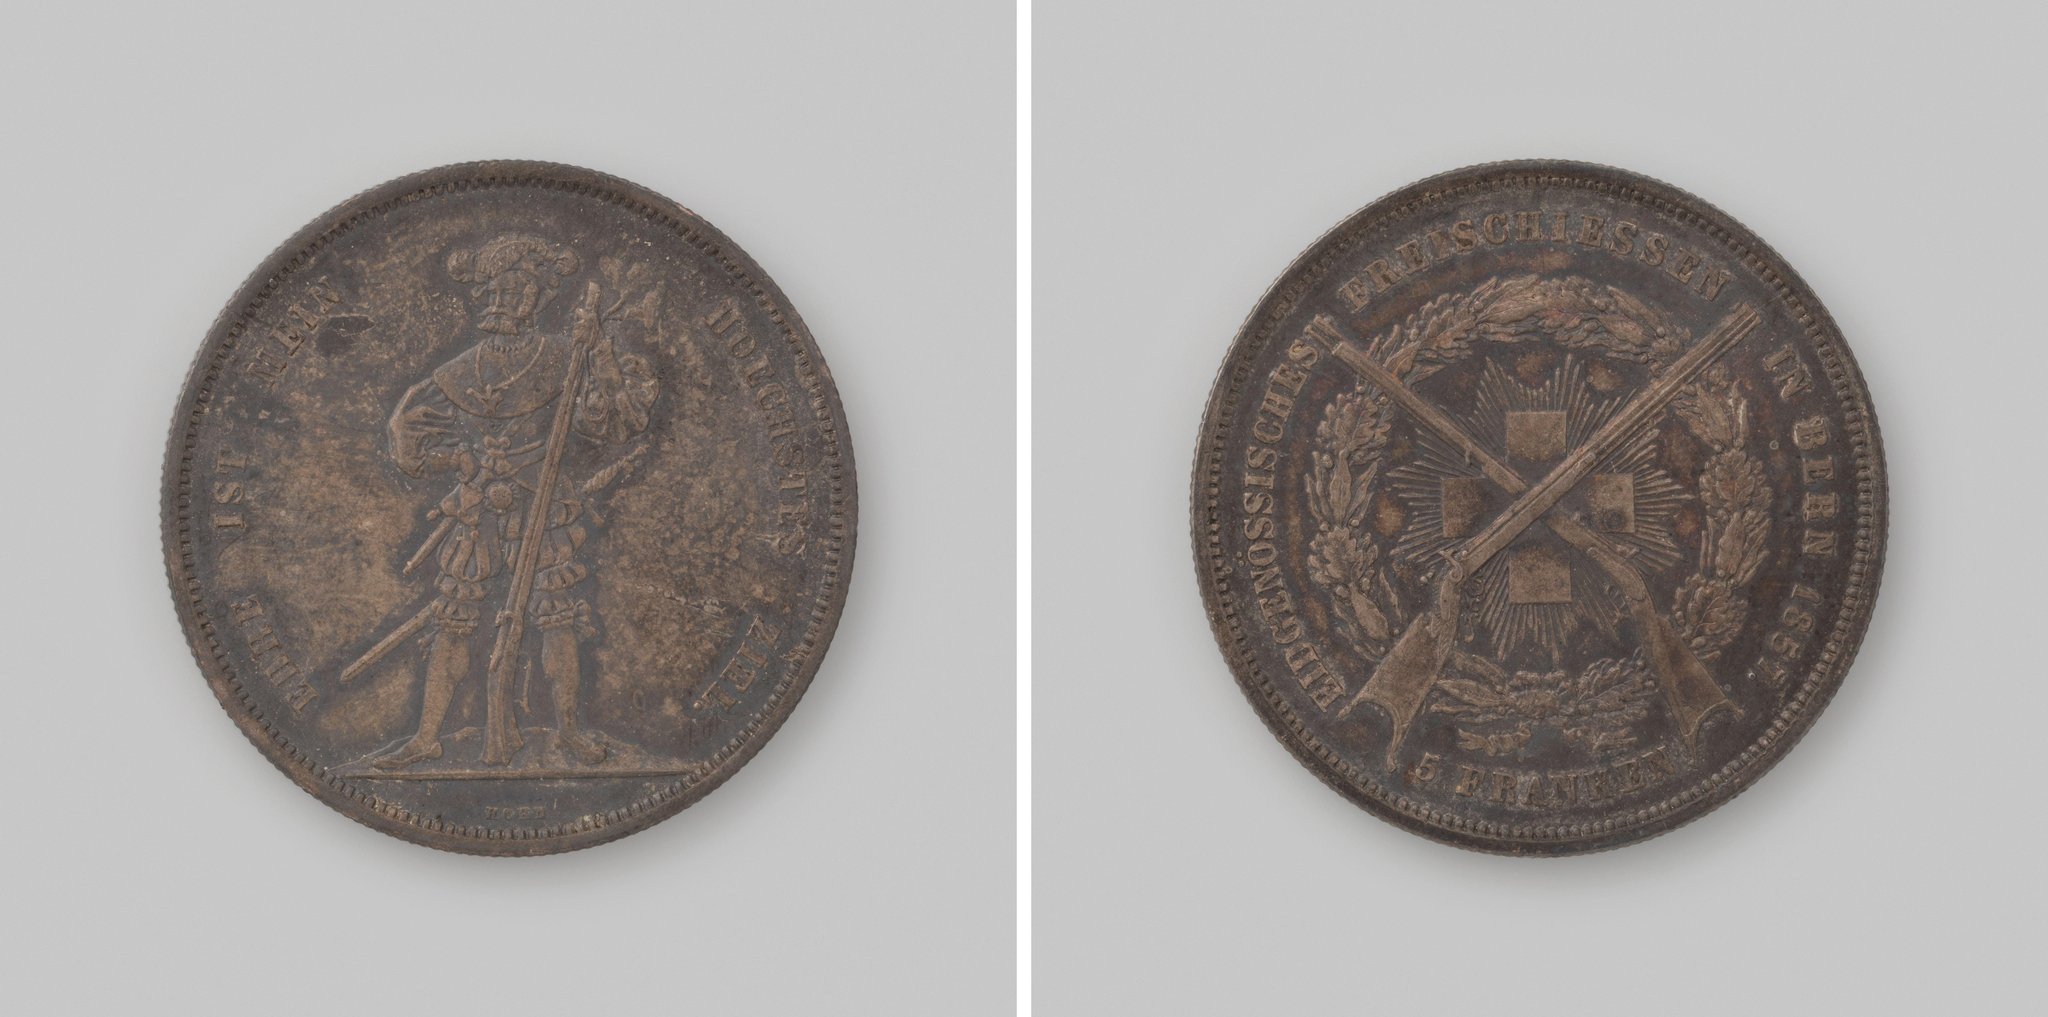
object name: coin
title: 5 franken uit Zwitserland, Freischiessen Bern, 1857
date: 1857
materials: silver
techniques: striking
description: Zilveren herdenkingsmunt. Voorzijde: binnen twee samengebonden takken door stralen omringde wapen van Zwitserland. Daar overheen twee geweren. Waarde-aanduiding: 5 franken en jaartal in omschrift. Keerzijde: staande schuitter met geweer en zwaard in middeleeuwse kledij. Kartelrand.